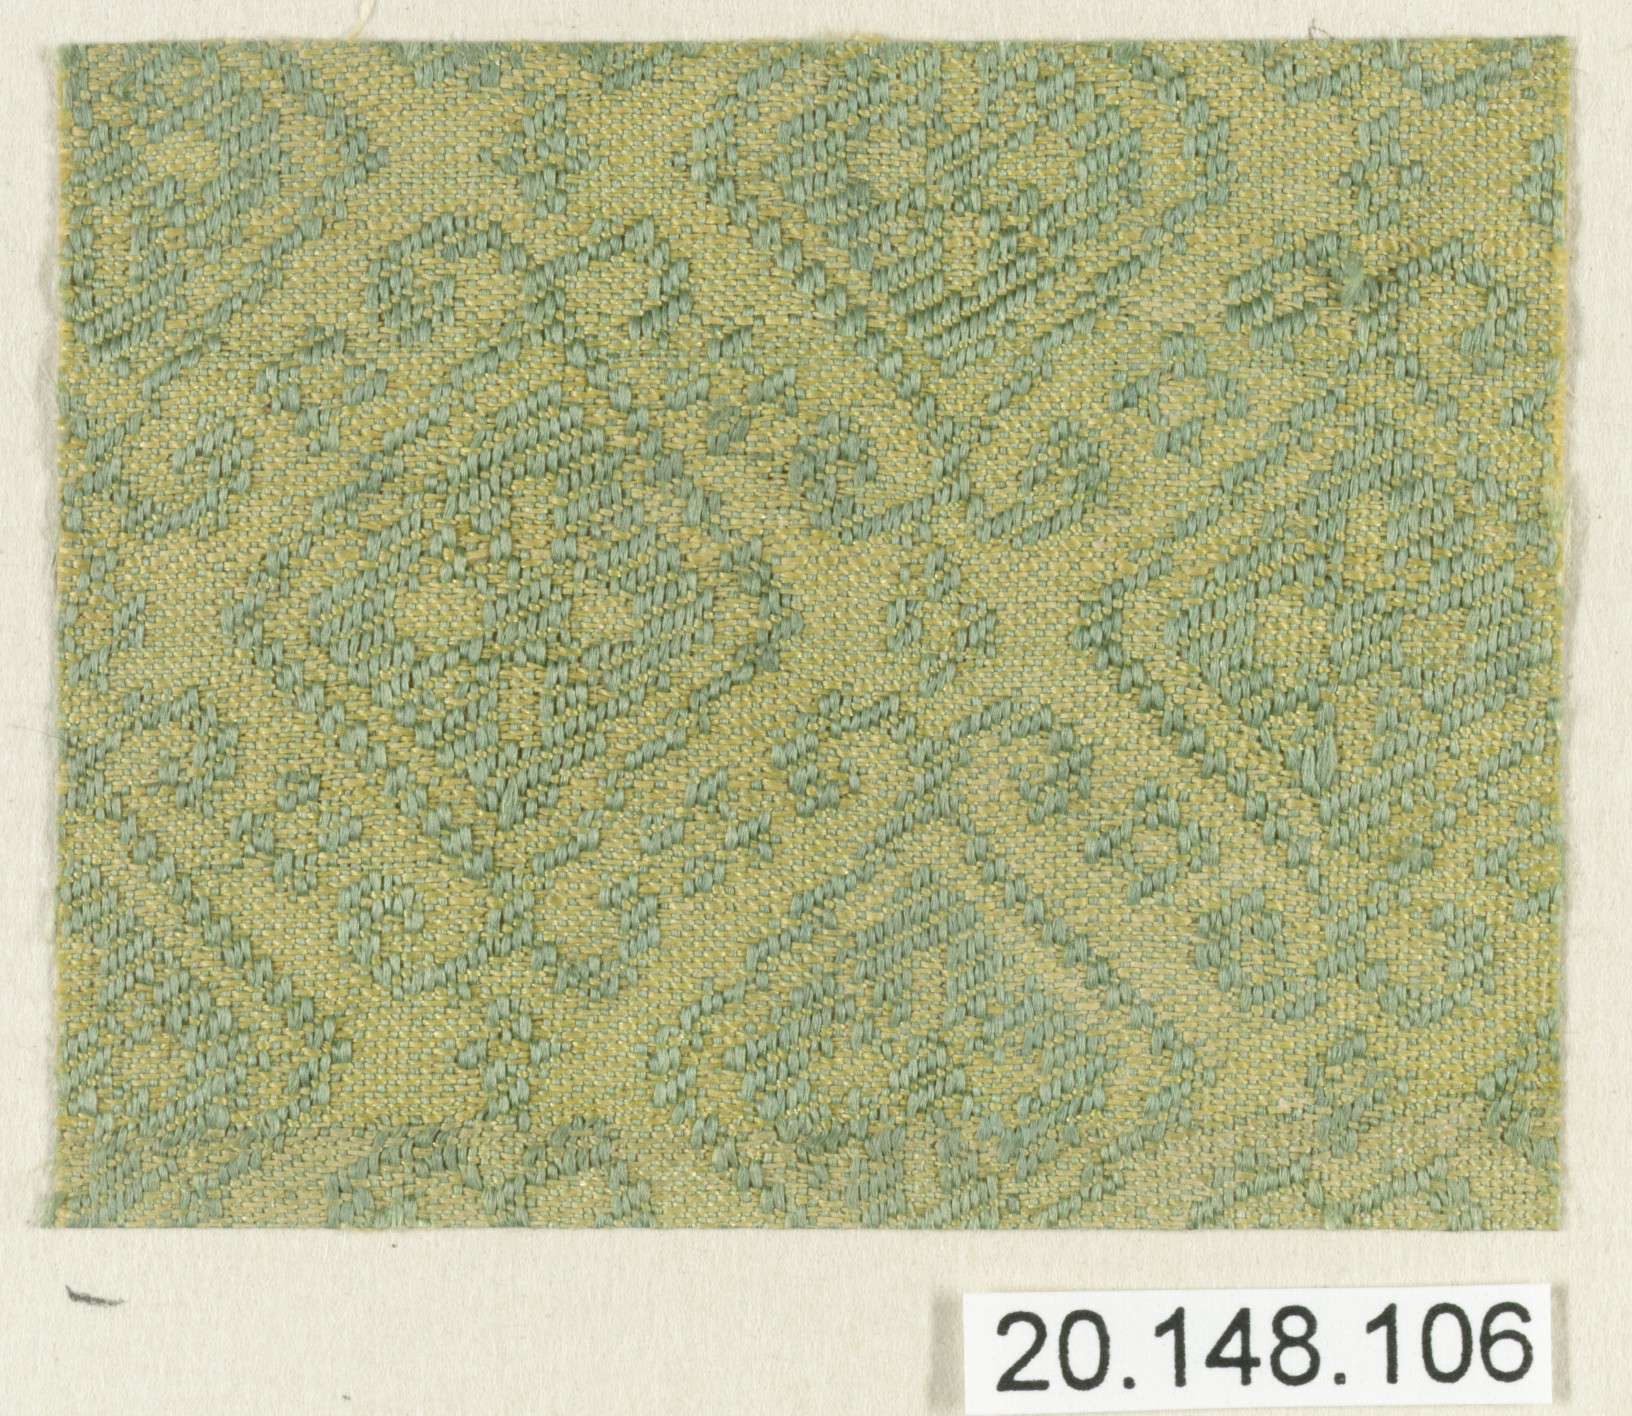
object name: piece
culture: japanese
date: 1601-1700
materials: silk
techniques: compound weave